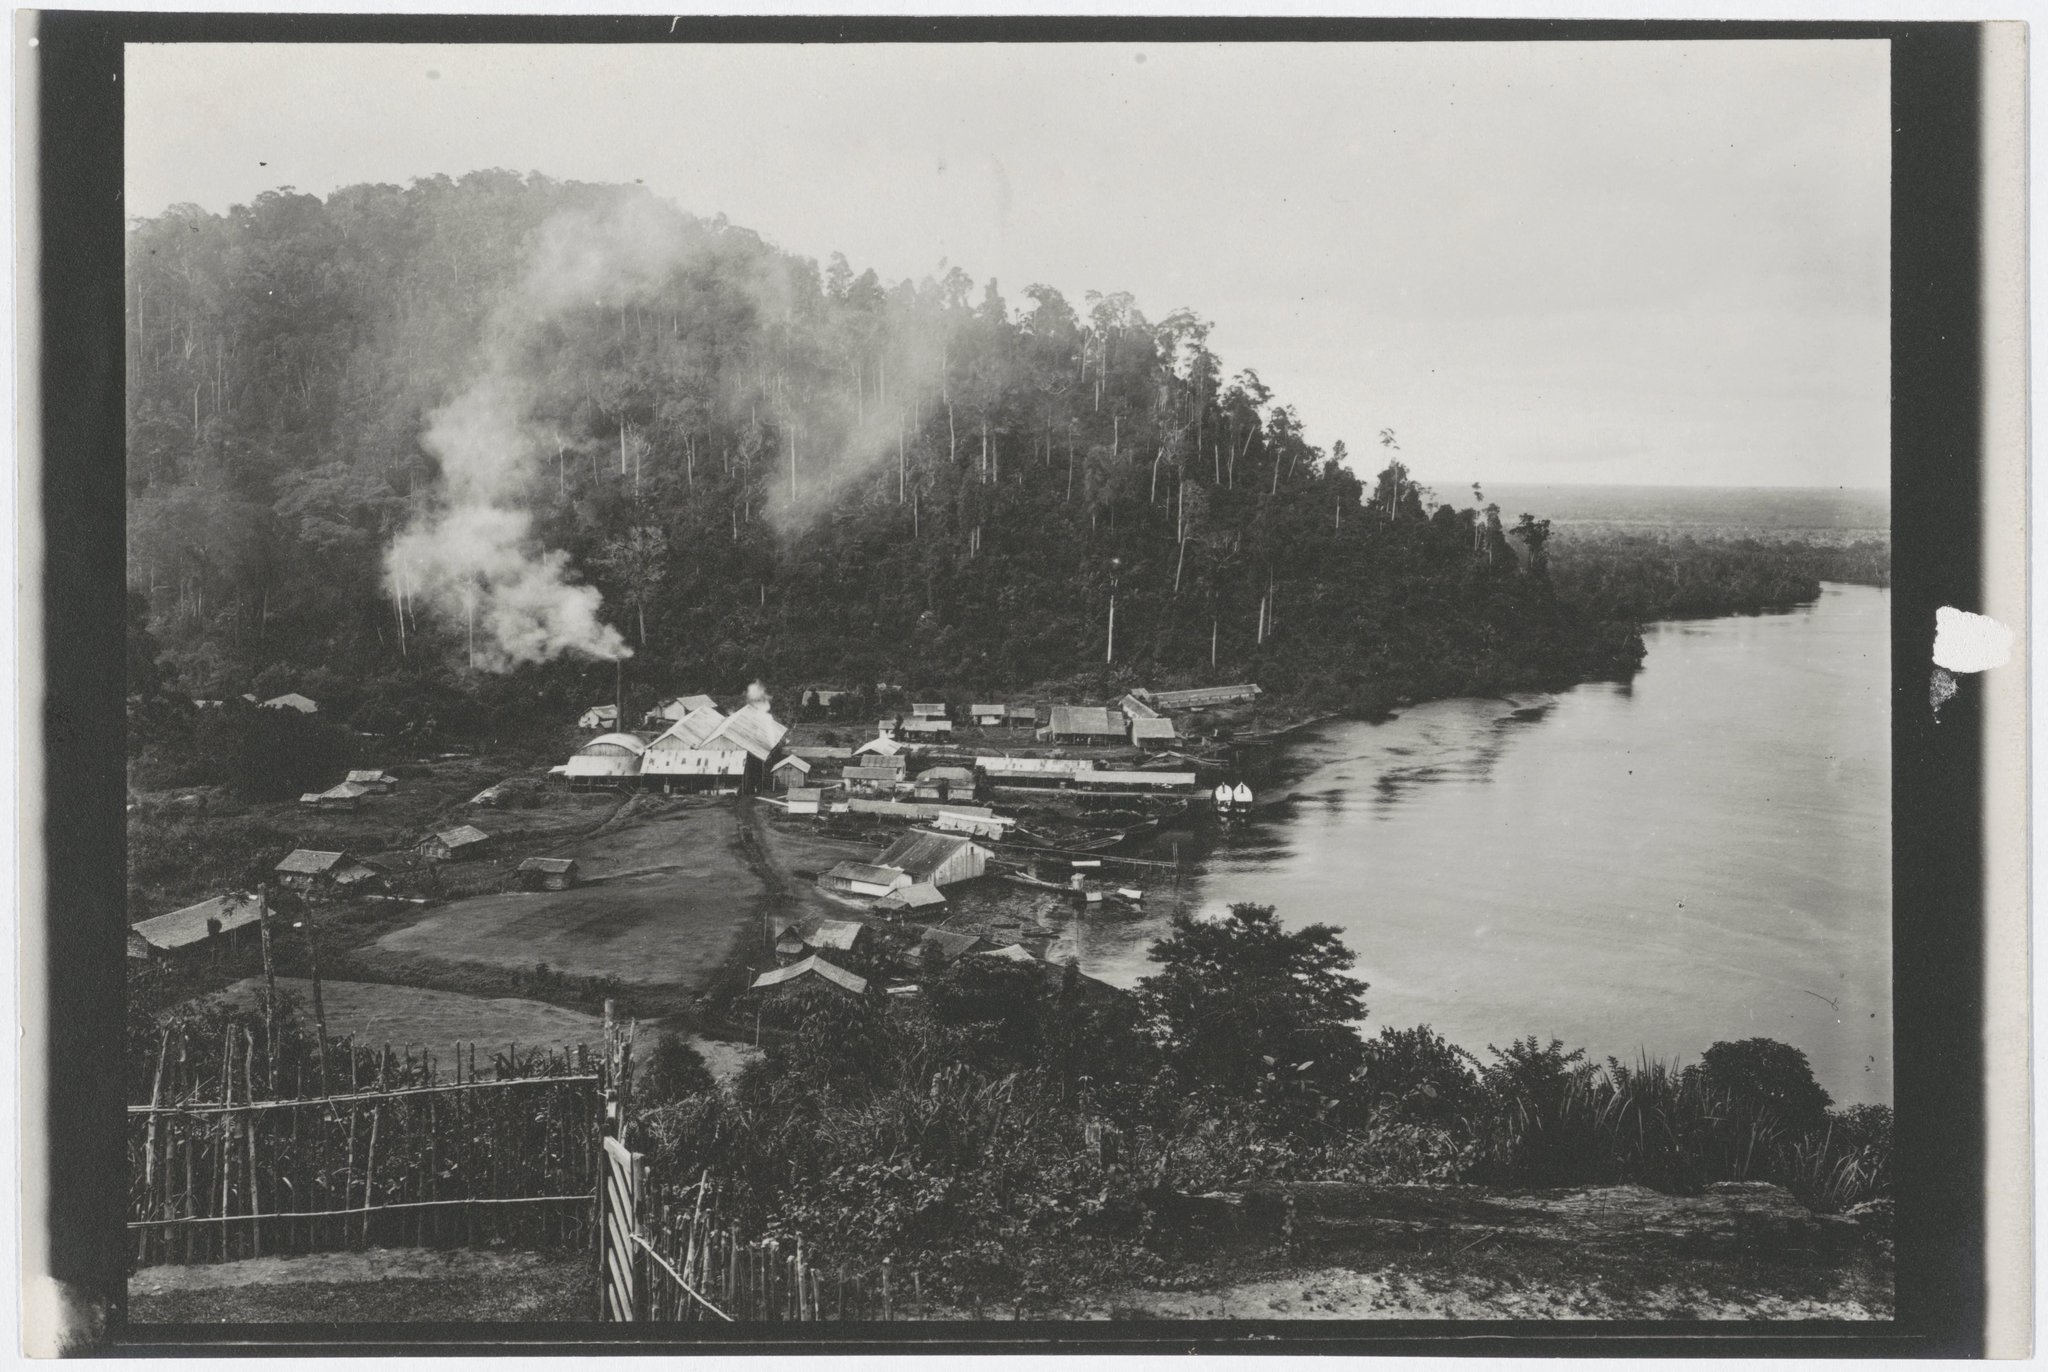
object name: photograph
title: Een fabriek in Telok, gelegen aan het water.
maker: johanna hermina marmelstein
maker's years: 1897-1990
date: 1900-1915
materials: paper, photographic support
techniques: albumen print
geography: jakarta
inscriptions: inscription: ‘Ingang van een aanzienlijk huis. Tempeltje, logis voor de huisgoden, stenen deurwachters.’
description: Een fabriek in Telok, gelegen aan het water. De fabriek heeft vele bijgebouwen en enkele aangemeerde boten.